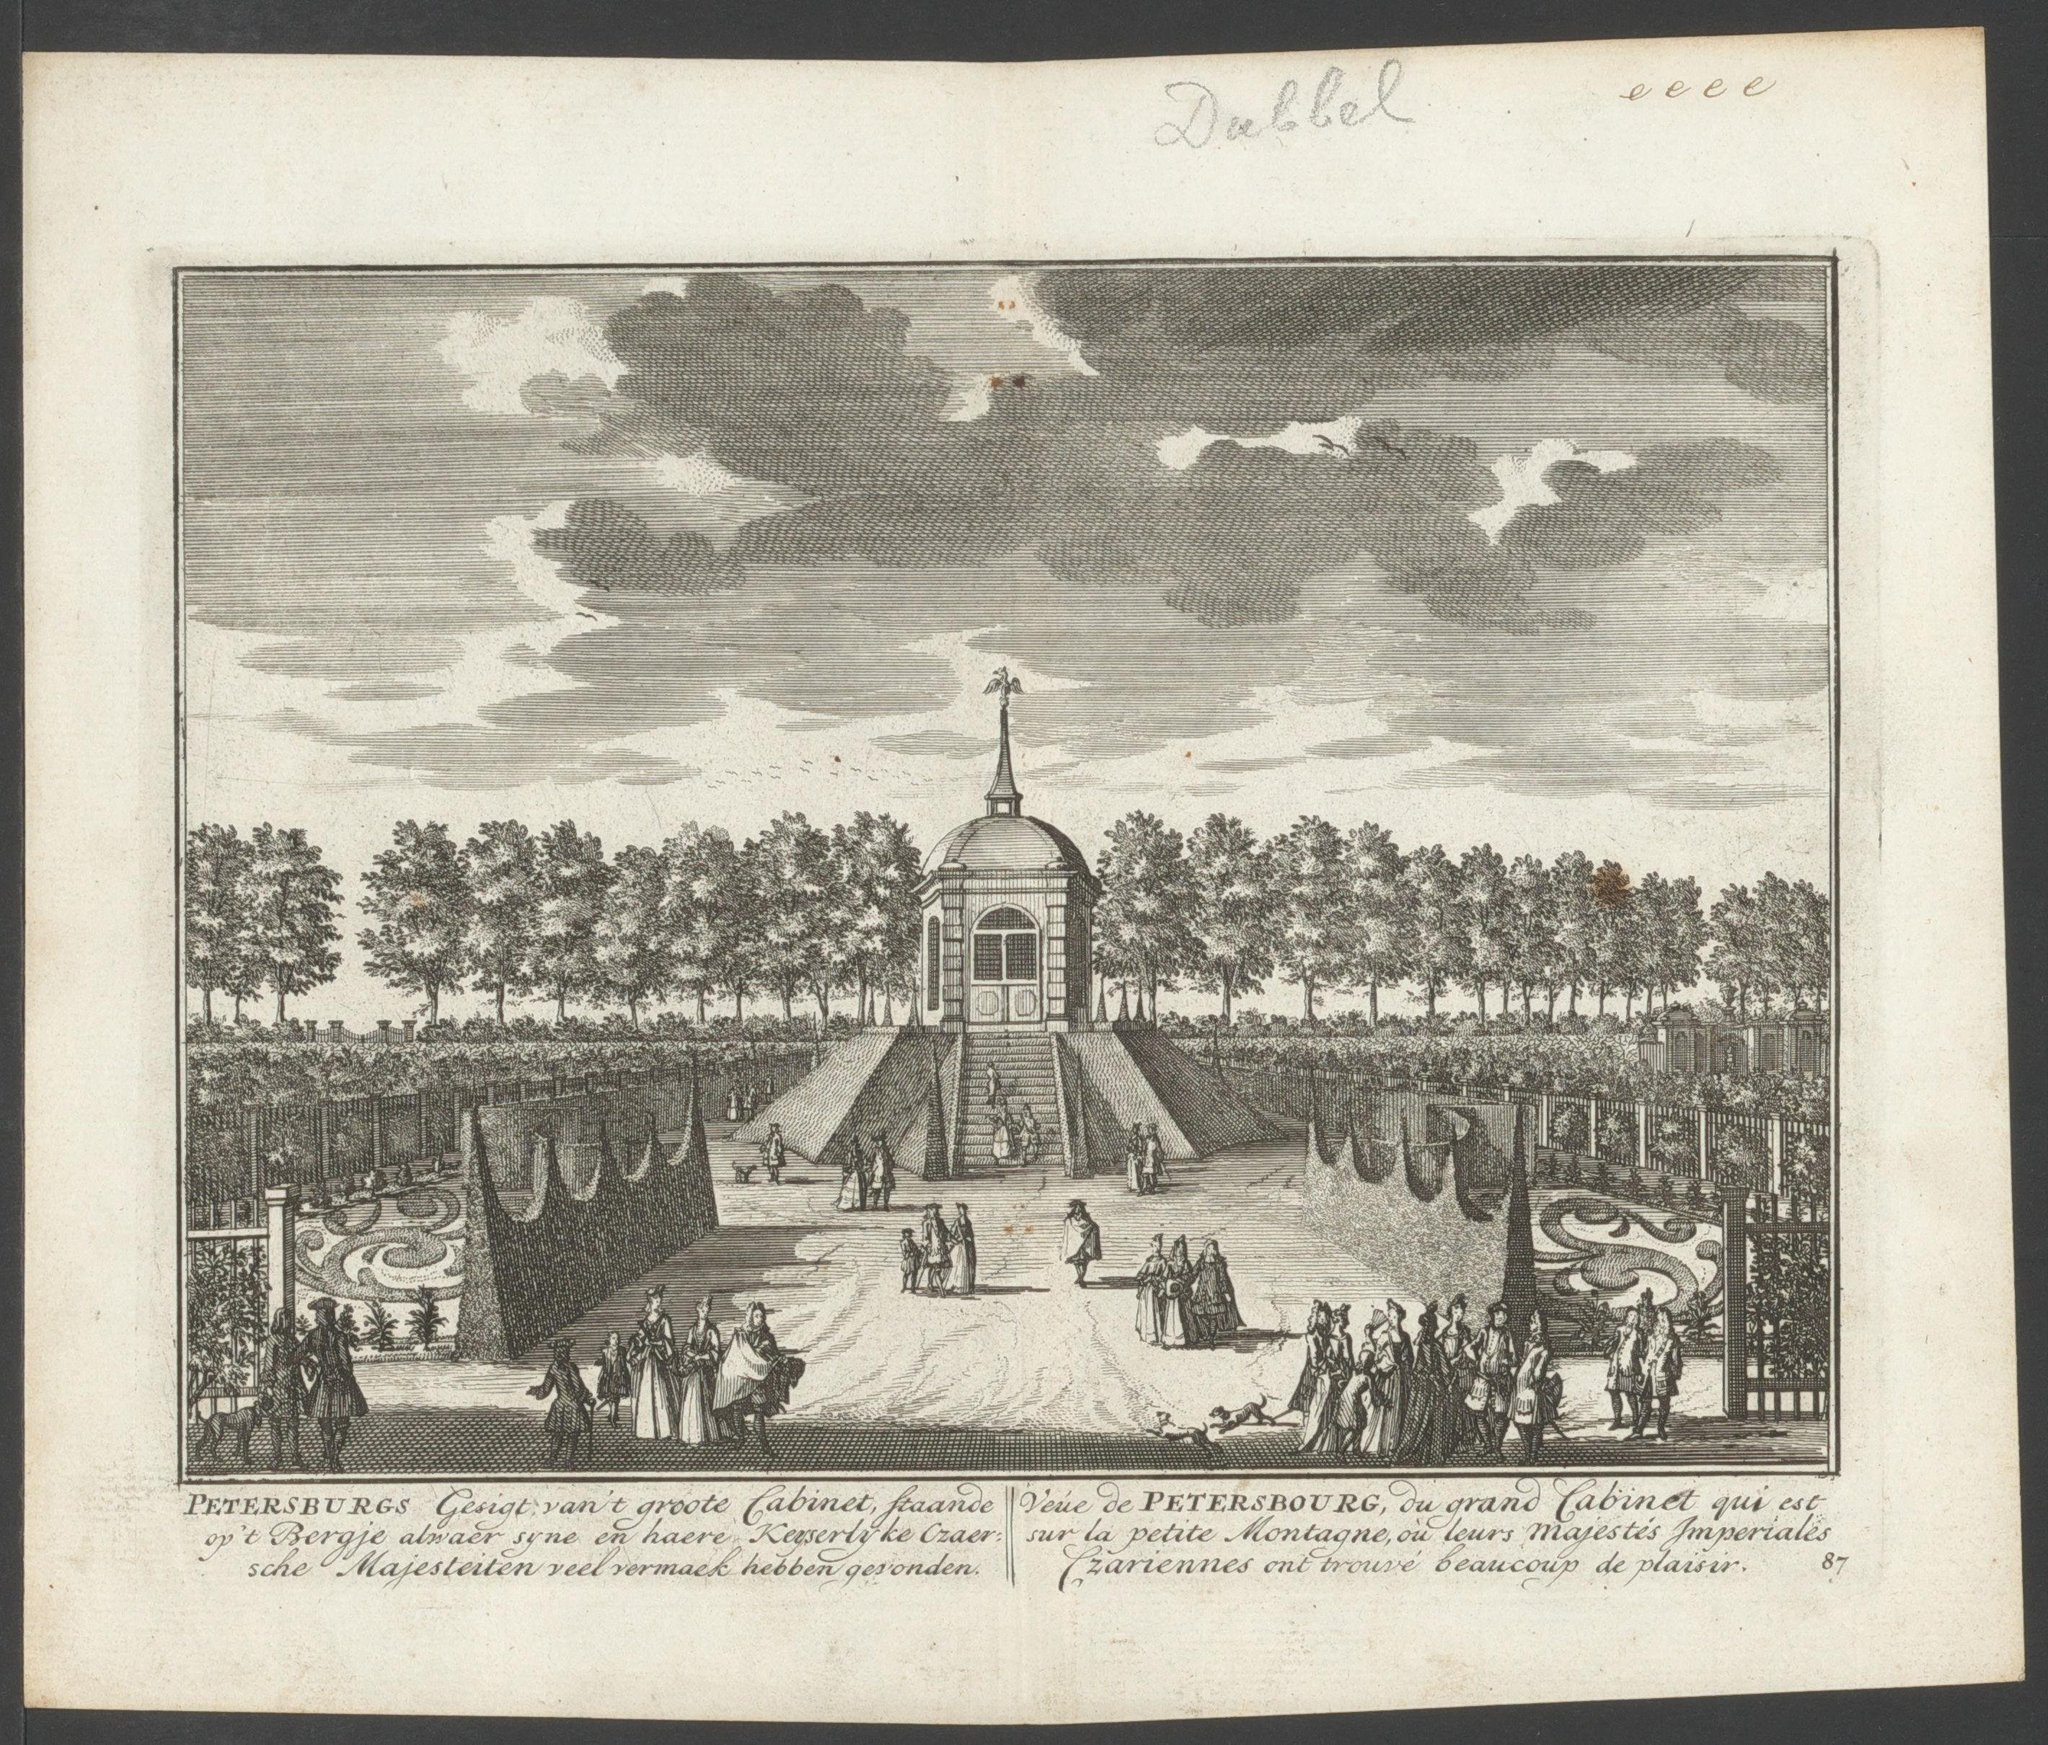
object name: print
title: Gezicht op het speelhuis van de buitenplaats Petersburg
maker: daniël stopendaal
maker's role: print maker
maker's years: 1672-1726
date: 1790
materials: paper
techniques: engraving, etching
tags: french or architectonic garden; formal garden, summer-house, arbour, garden-house (dutch: 'theekoepel'), belvedere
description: Prent voor het eerst gebruikt in: Leth, Andries de. De zegepraalende Vecht, vertoonende verscheidene gesichten van lustplaatsen, heeren huysen en dorpen, beginnende van Uitrecht en met Muyden besluytende (...). Amsterdam: Weduwe Nicolaus Visscher, 1719. Prent mogelijk uit: Brouërius van Nidek, Matthaeus. De Vechtstroom, van Utrecht tot Muiden (...). Amsterdam: H. Gartman, W. Vermandel en J.W. Smit, 1790.